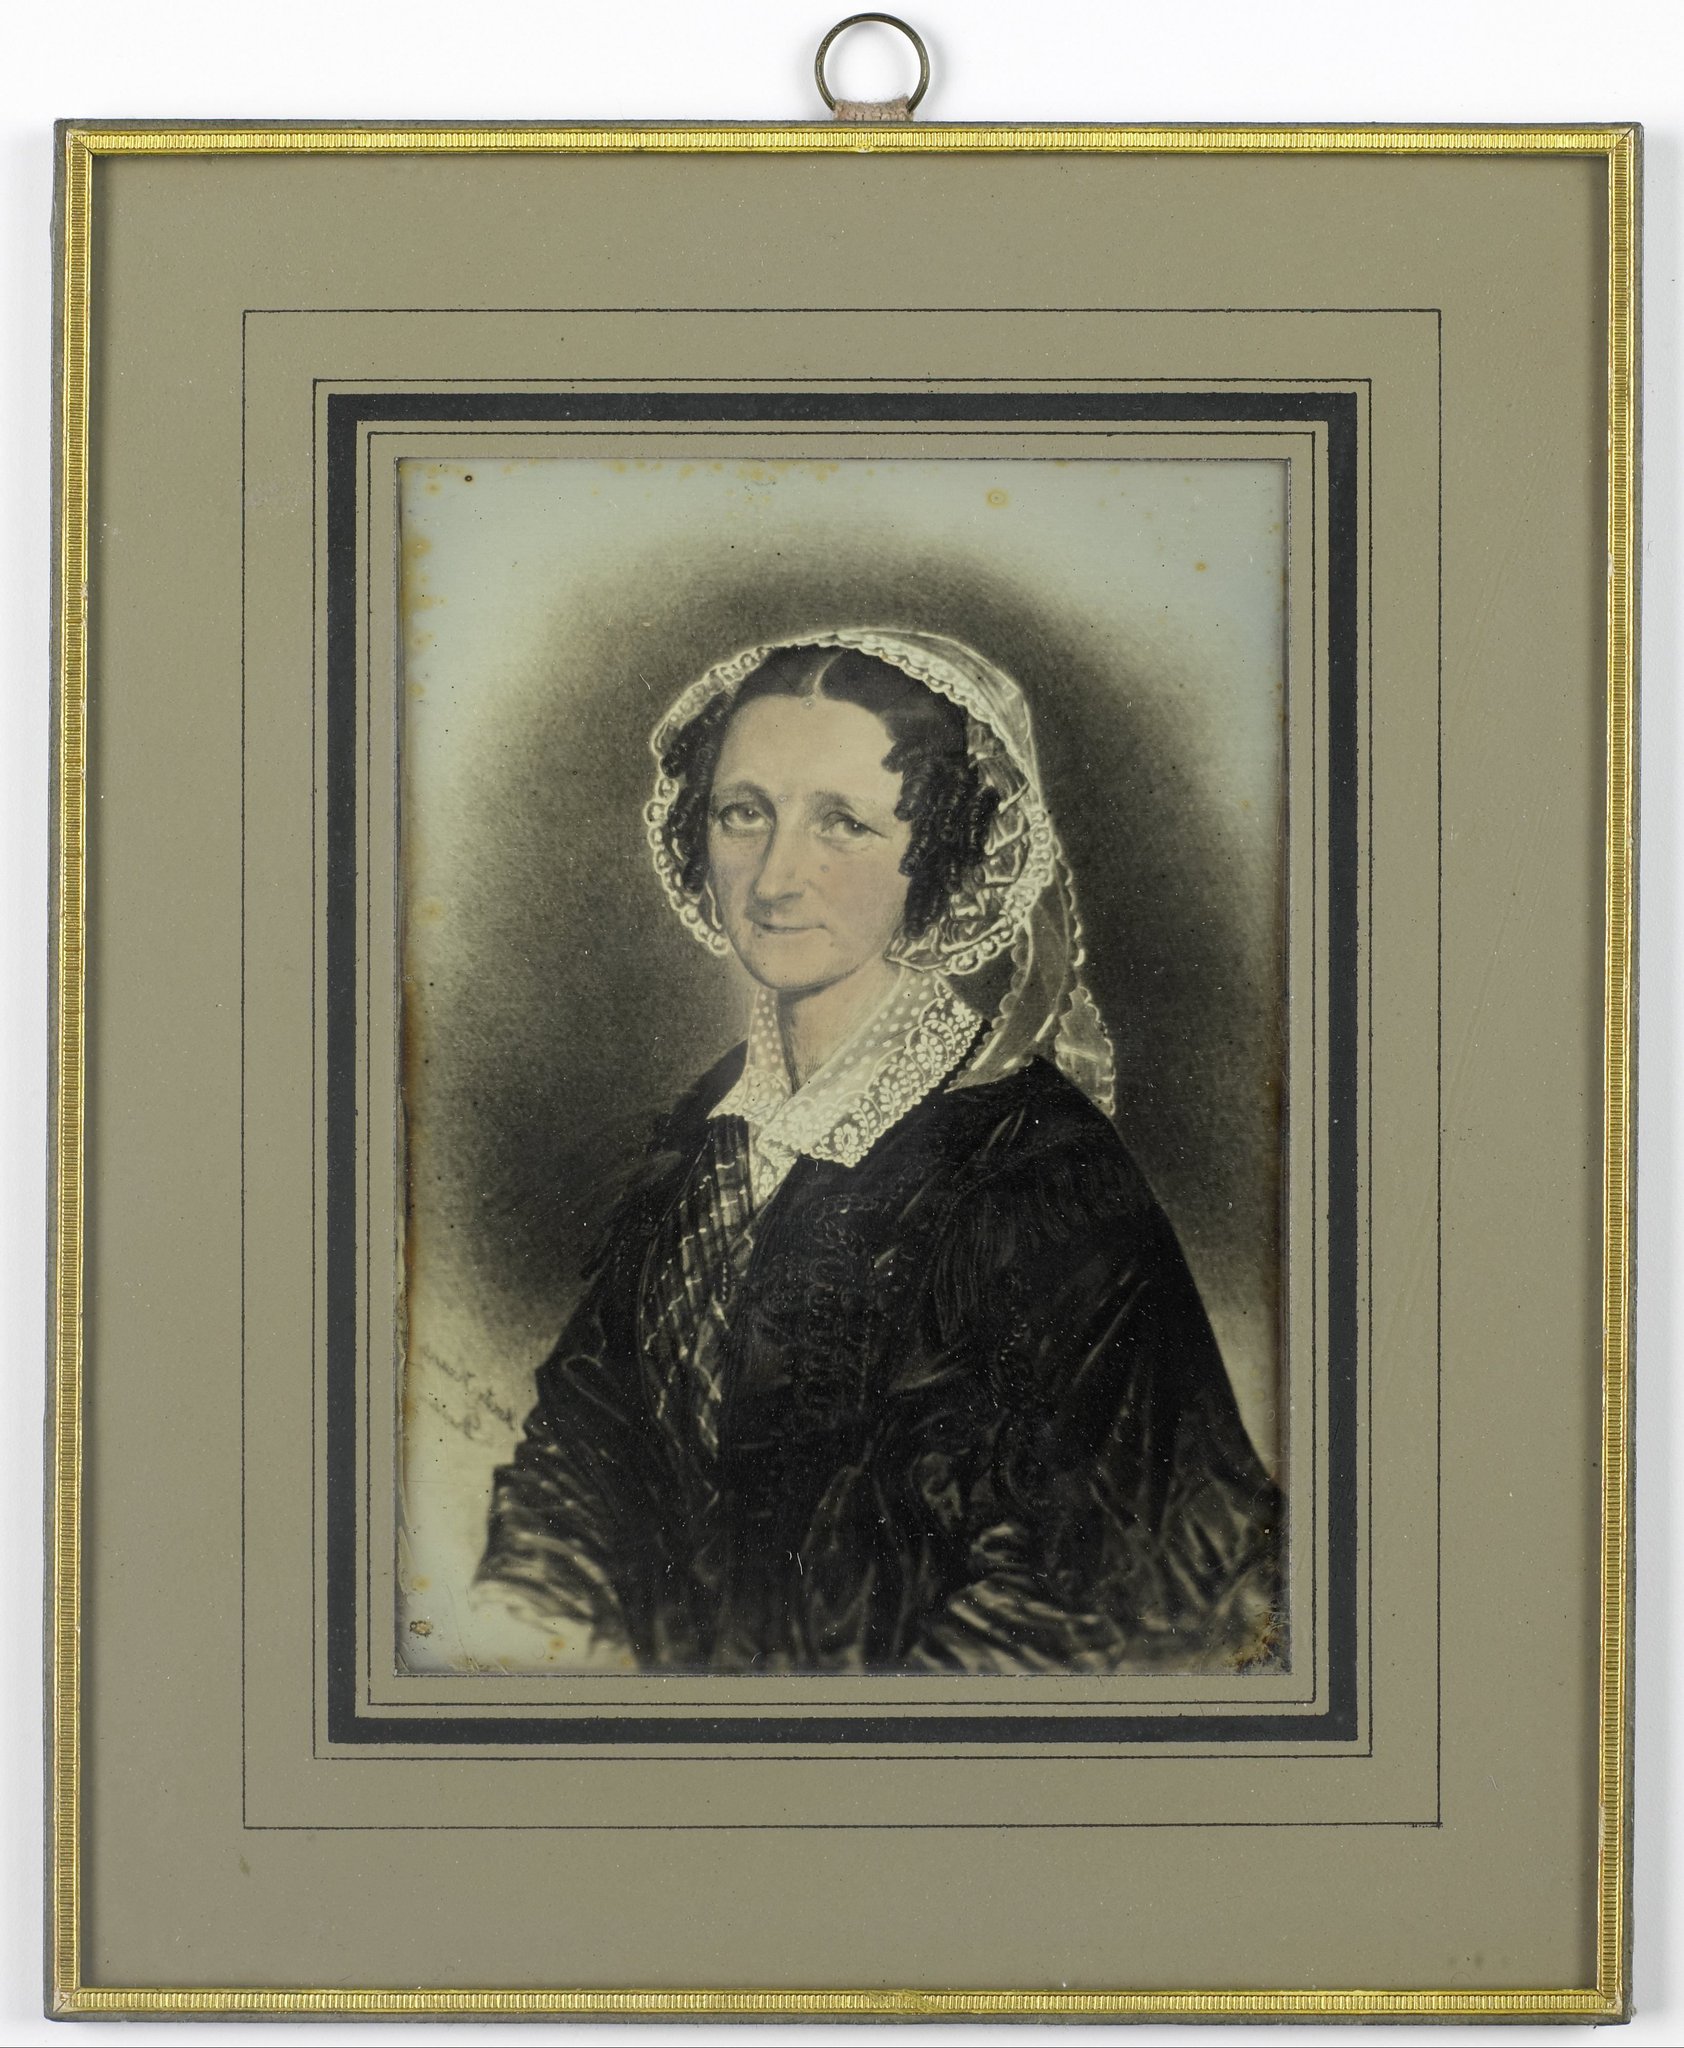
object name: photograph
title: Portret van een onbekende vrouw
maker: Anonymous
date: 1840-1860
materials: copper, glass, paper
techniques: daguerreotype, hand coloring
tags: adult woman, historical persons